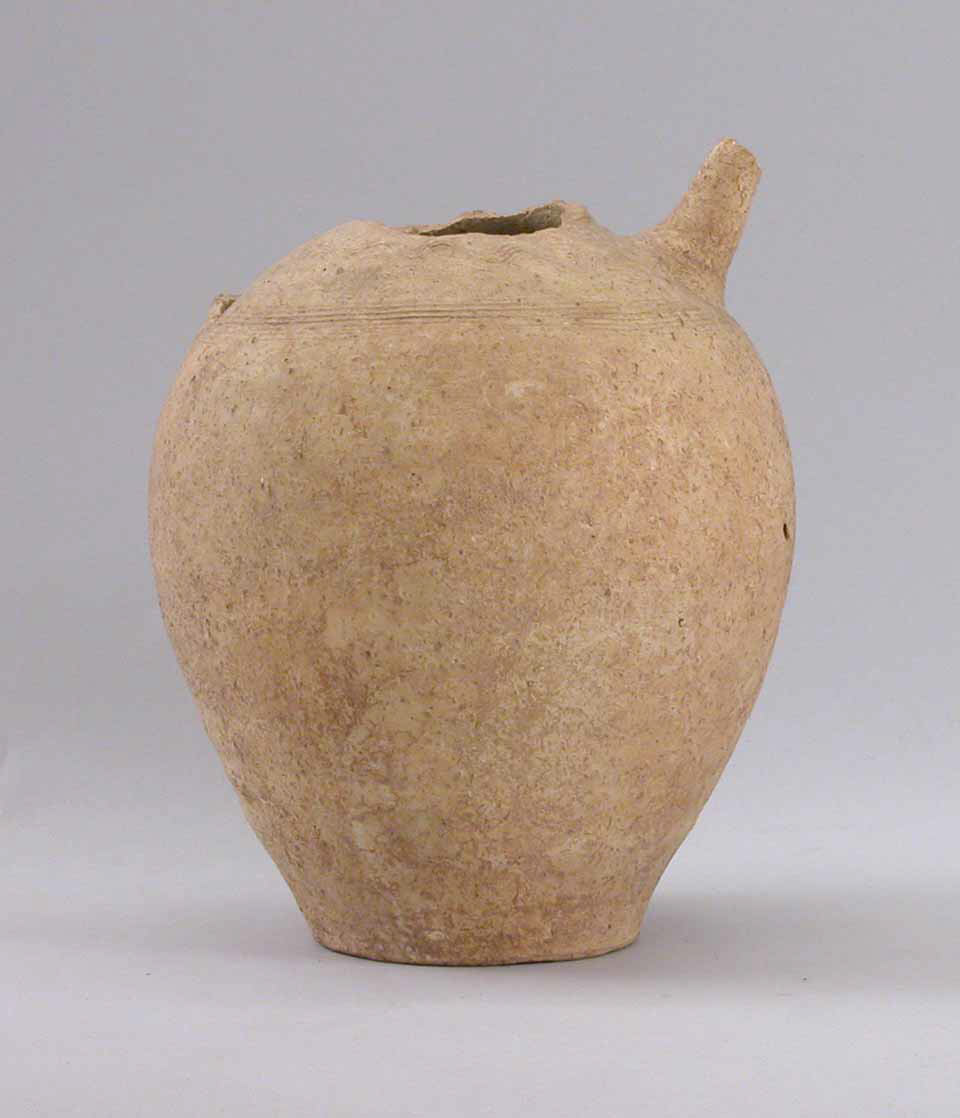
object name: jar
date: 701-900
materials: earthenware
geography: iran